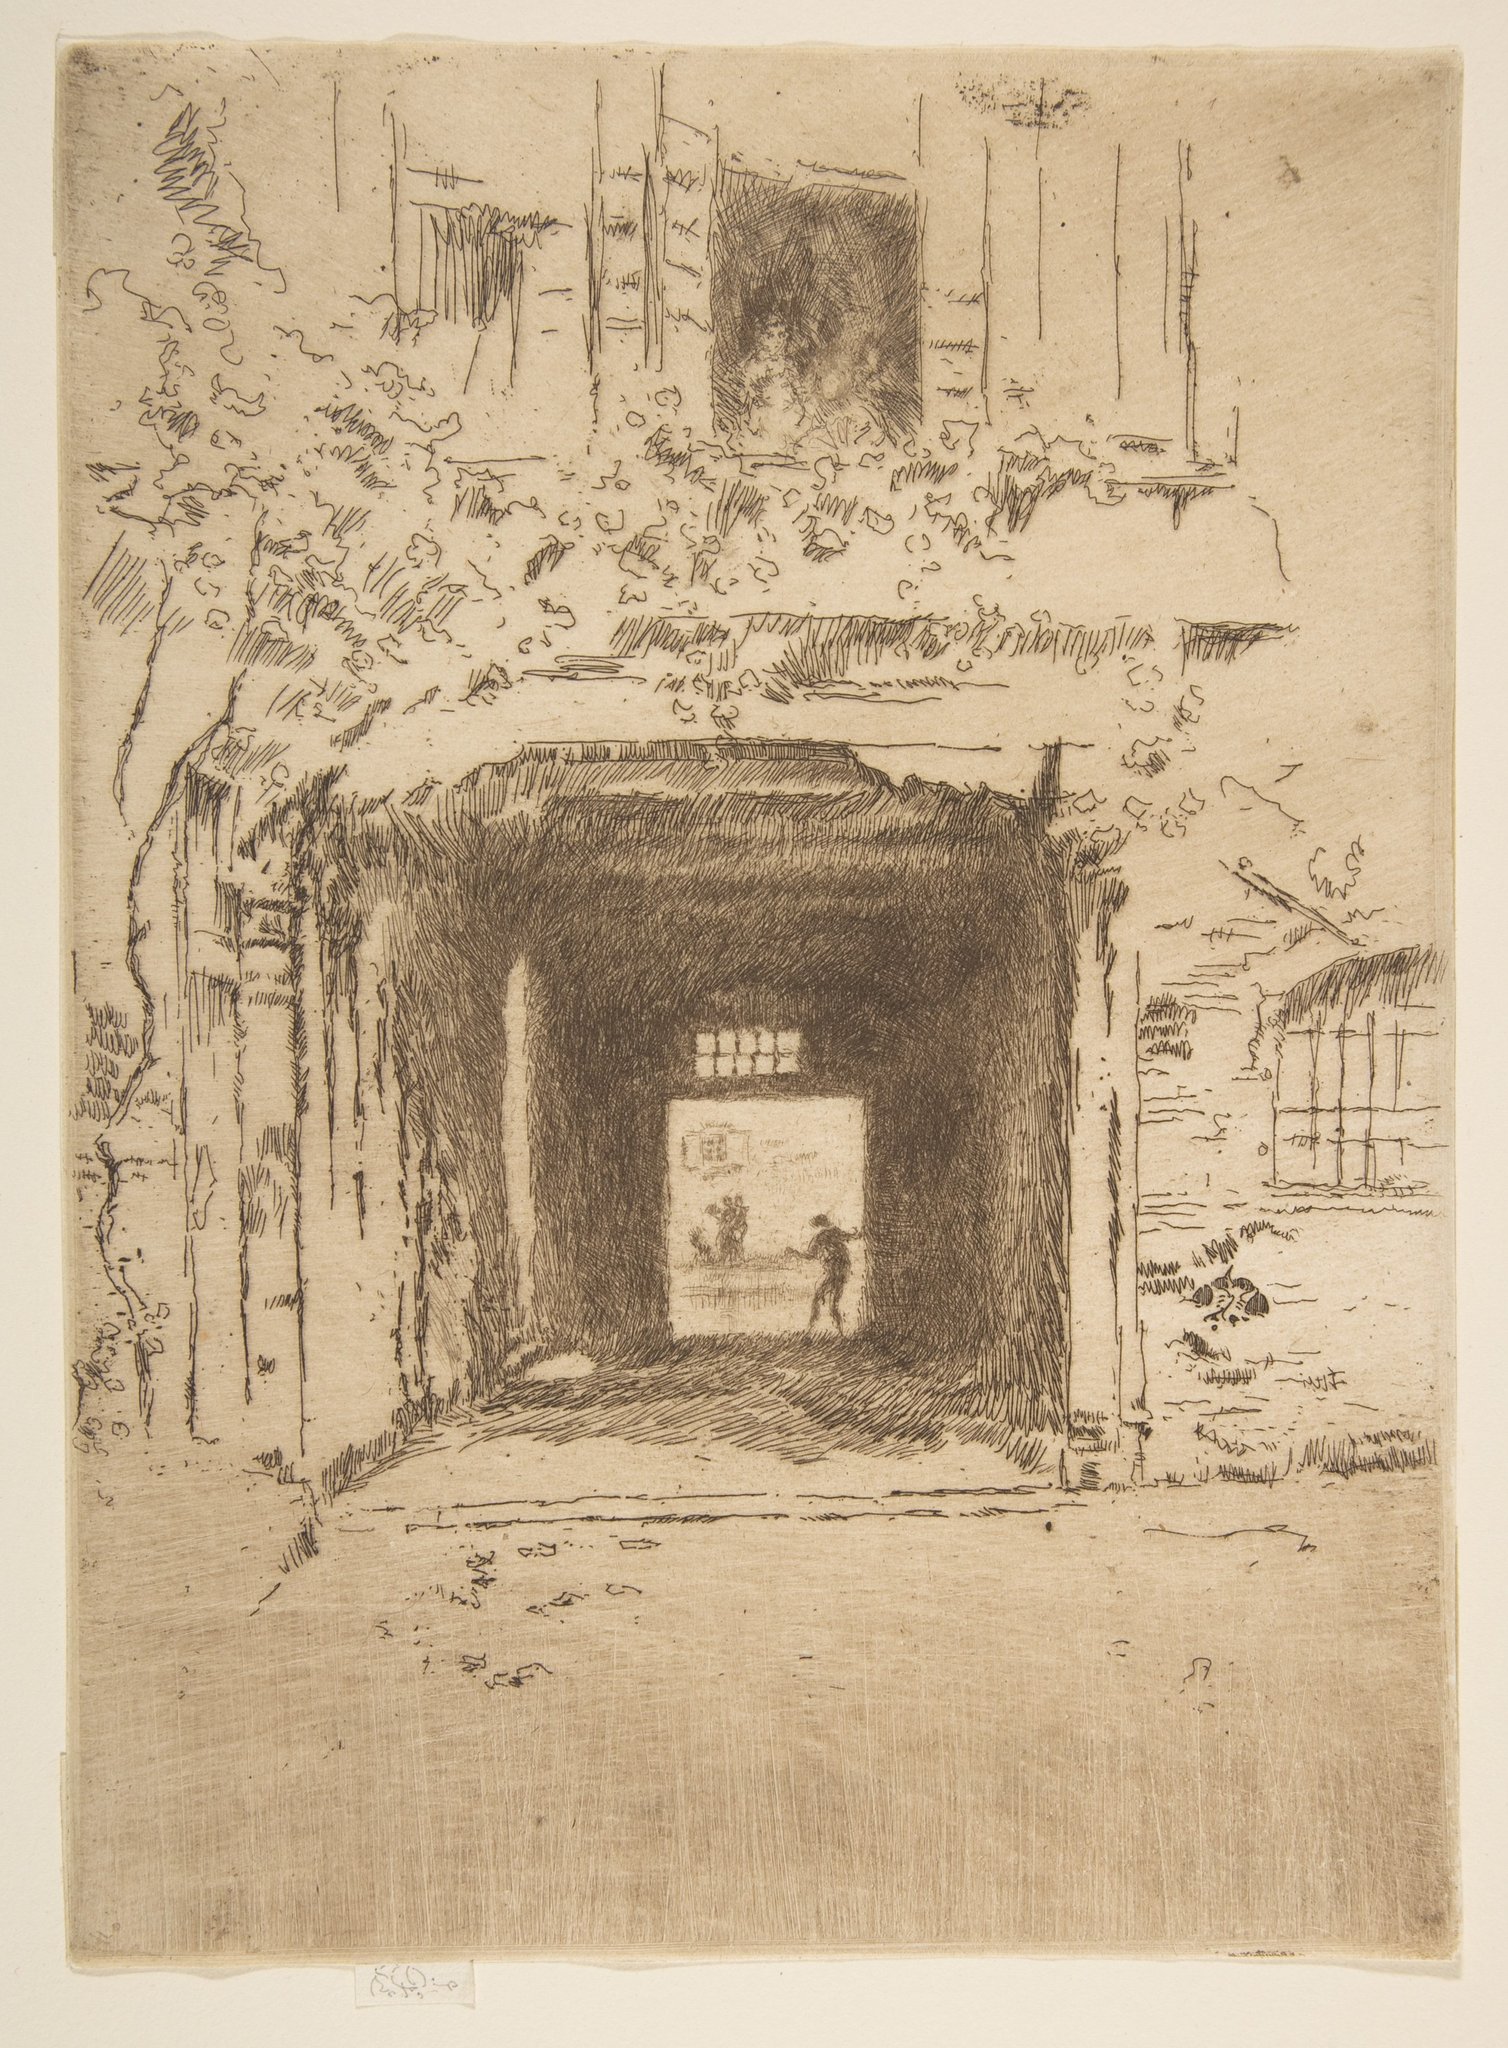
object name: print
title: Doorway and Vine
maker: james mcneill whistler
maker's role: artist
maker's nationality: american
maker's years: 1834-1903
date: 1879-1880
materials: ink, paper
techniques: drypoint, etching, printing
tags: doorways,vines,venice